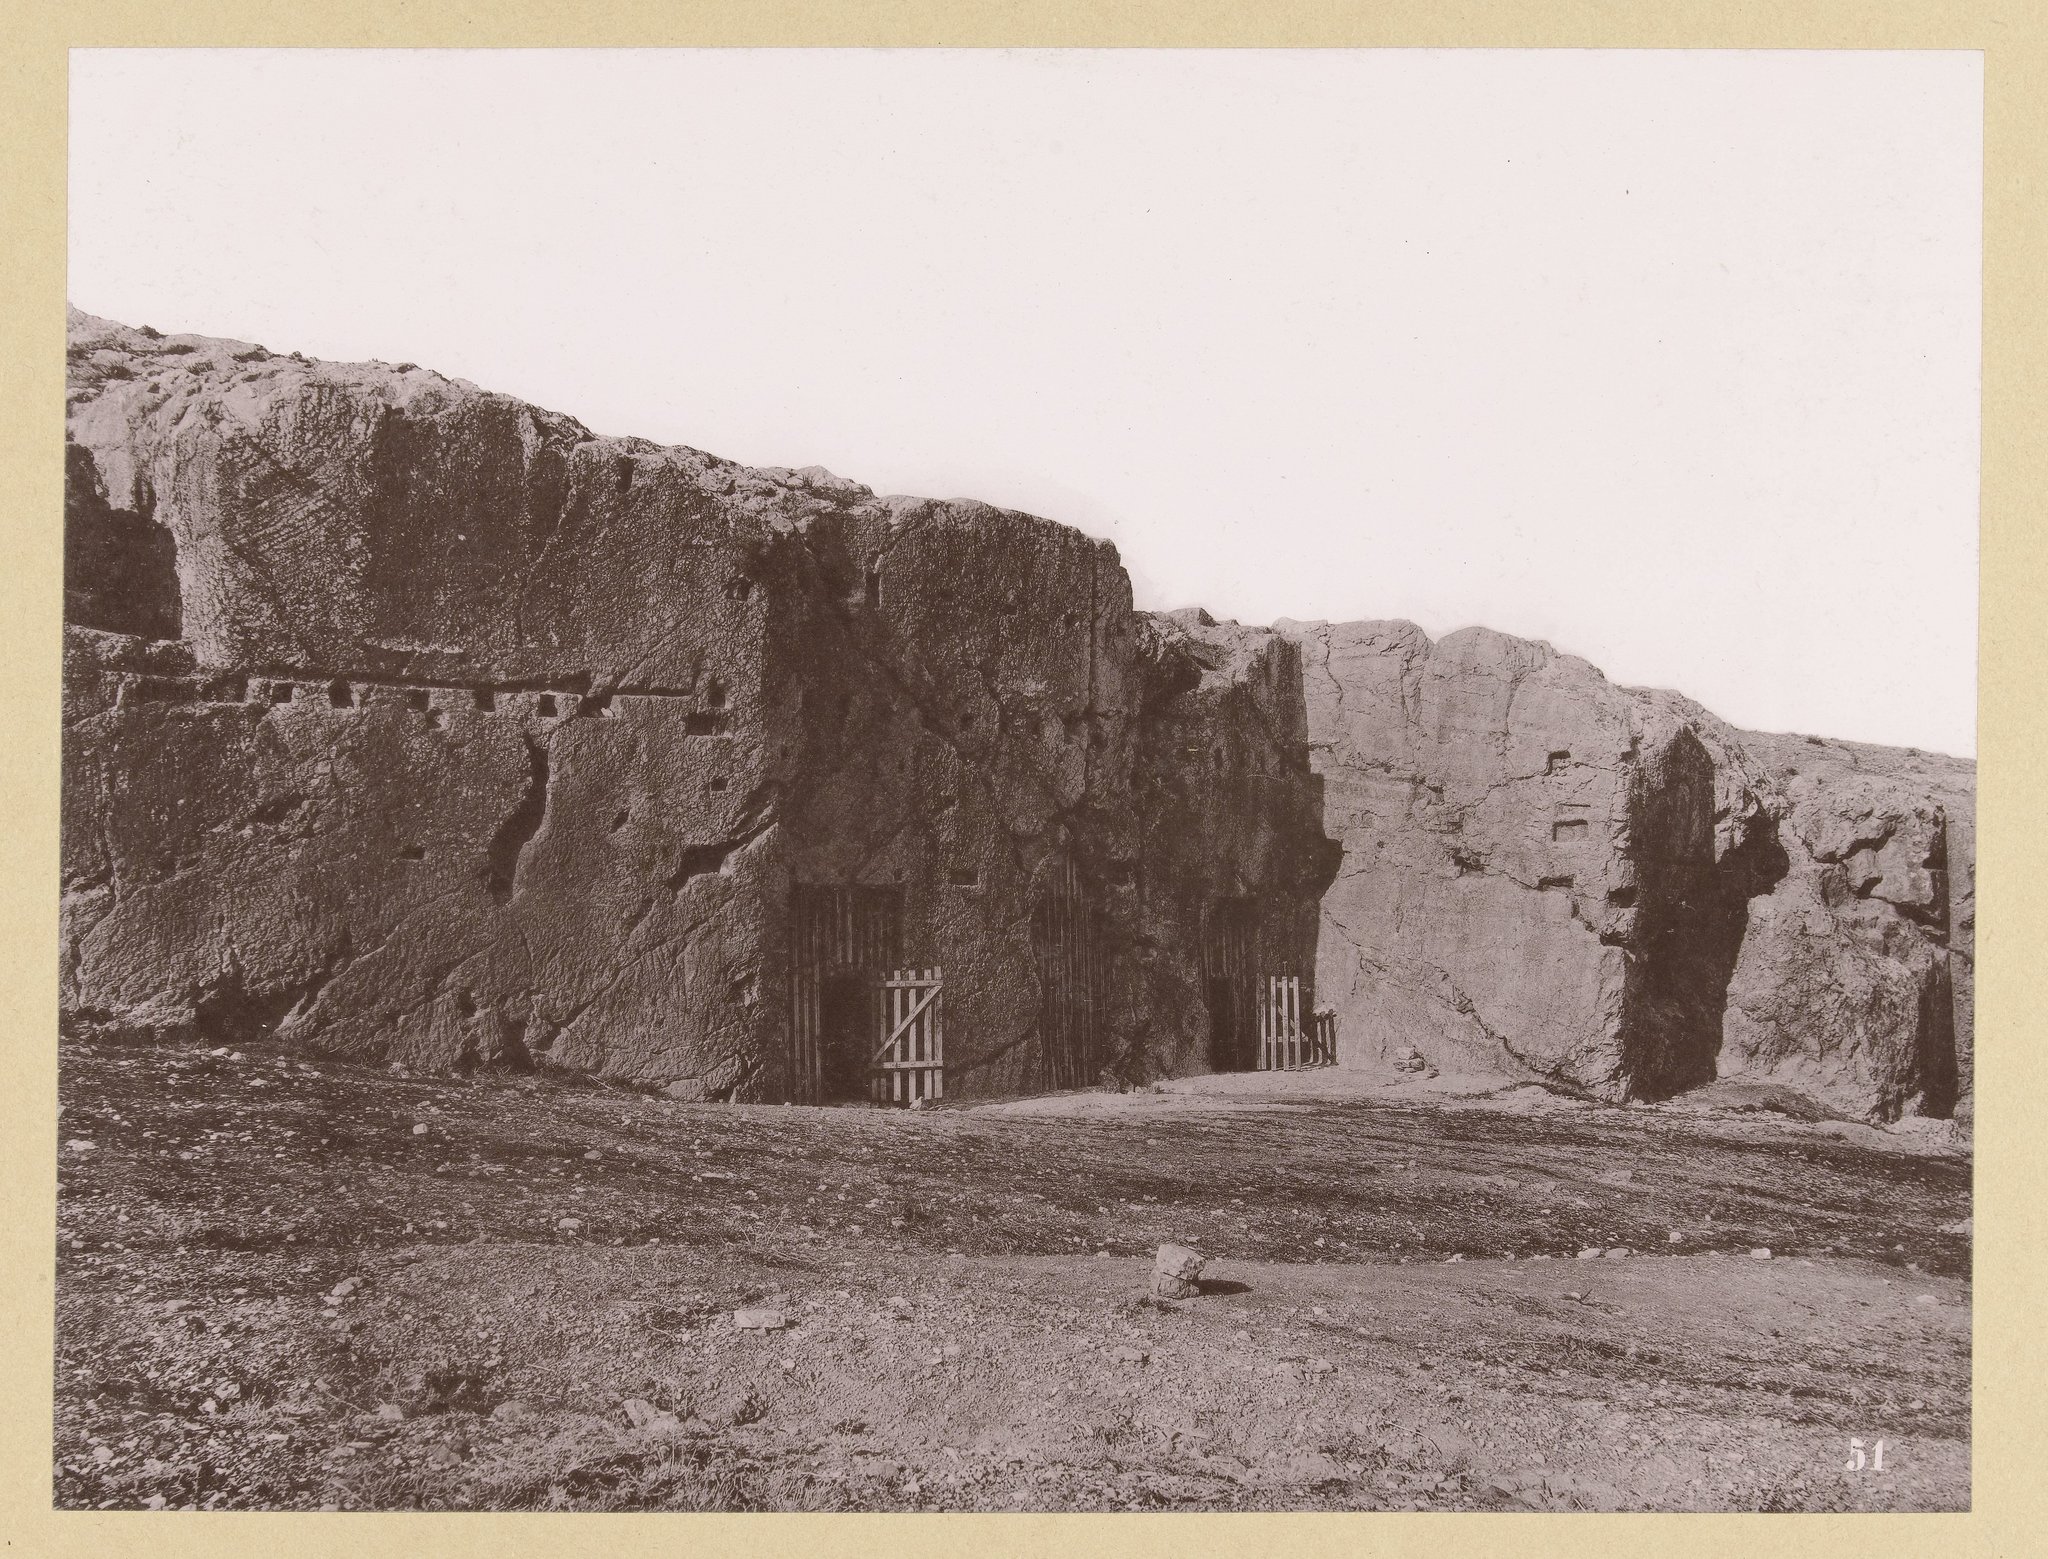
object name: photomechanical print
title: Gevangenis van Socrates in Athene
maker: Anonymous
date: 1890-1895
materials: cardboard, paper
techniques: photograph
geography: athens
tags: prison, jail, rock-formations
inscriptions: title: ‘G 14. Gevangenis van Socrates. Athene.’, check stamp: ‘Bristol/ L.M.’, stamp: ‘Gemeentelijke bibliotheek/ Rotterdam’, number: ‘51’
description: Onderdeel van een groep door fotograaf Richard Polak op reis verzamelde foto’s. Deze fotomechanische afdruk is samen met andere op zijn reizen verzamelde foto's tentoongesteld bij de Rotterdamsche Kunstkring (1895), Arti en Amicitiae te Amsterdam (1897-1898?) en Societeit 't Collegie te Kampen (datum vooralsnog onbekend).